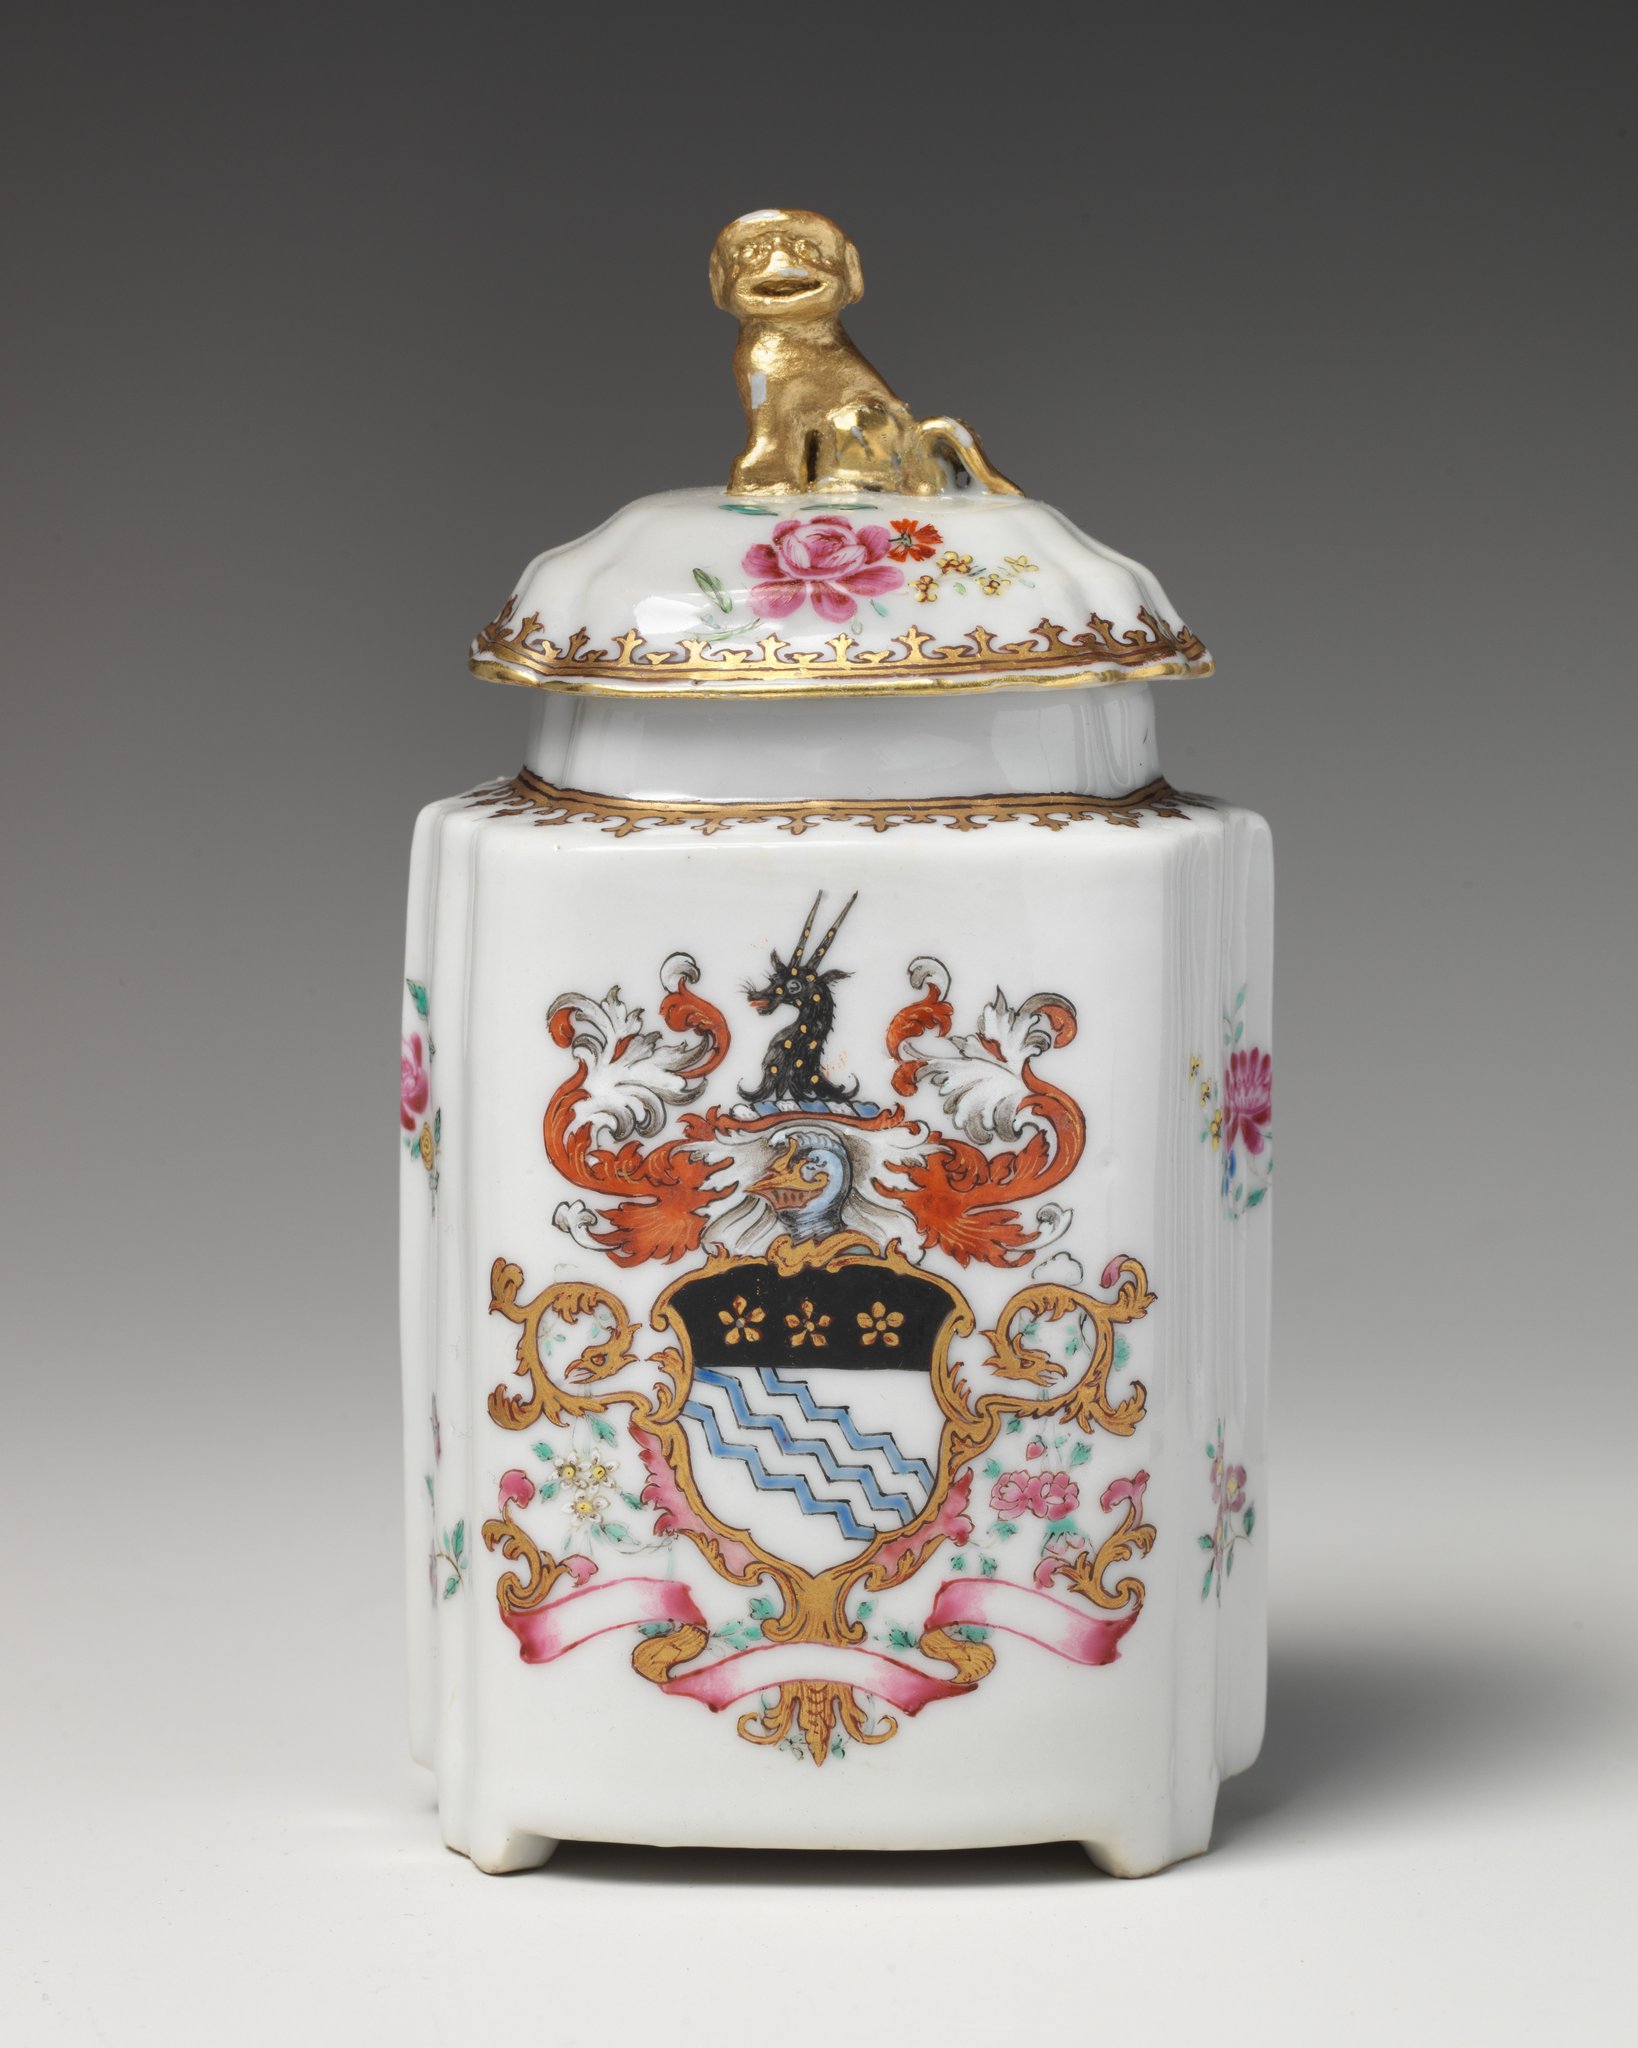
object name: tea caddy with cover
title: Tea caddy with cover with armorial decoration (part of a service)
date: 1750-1760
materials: enamel, hard paste porcelain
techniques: gilding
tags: coat of arms